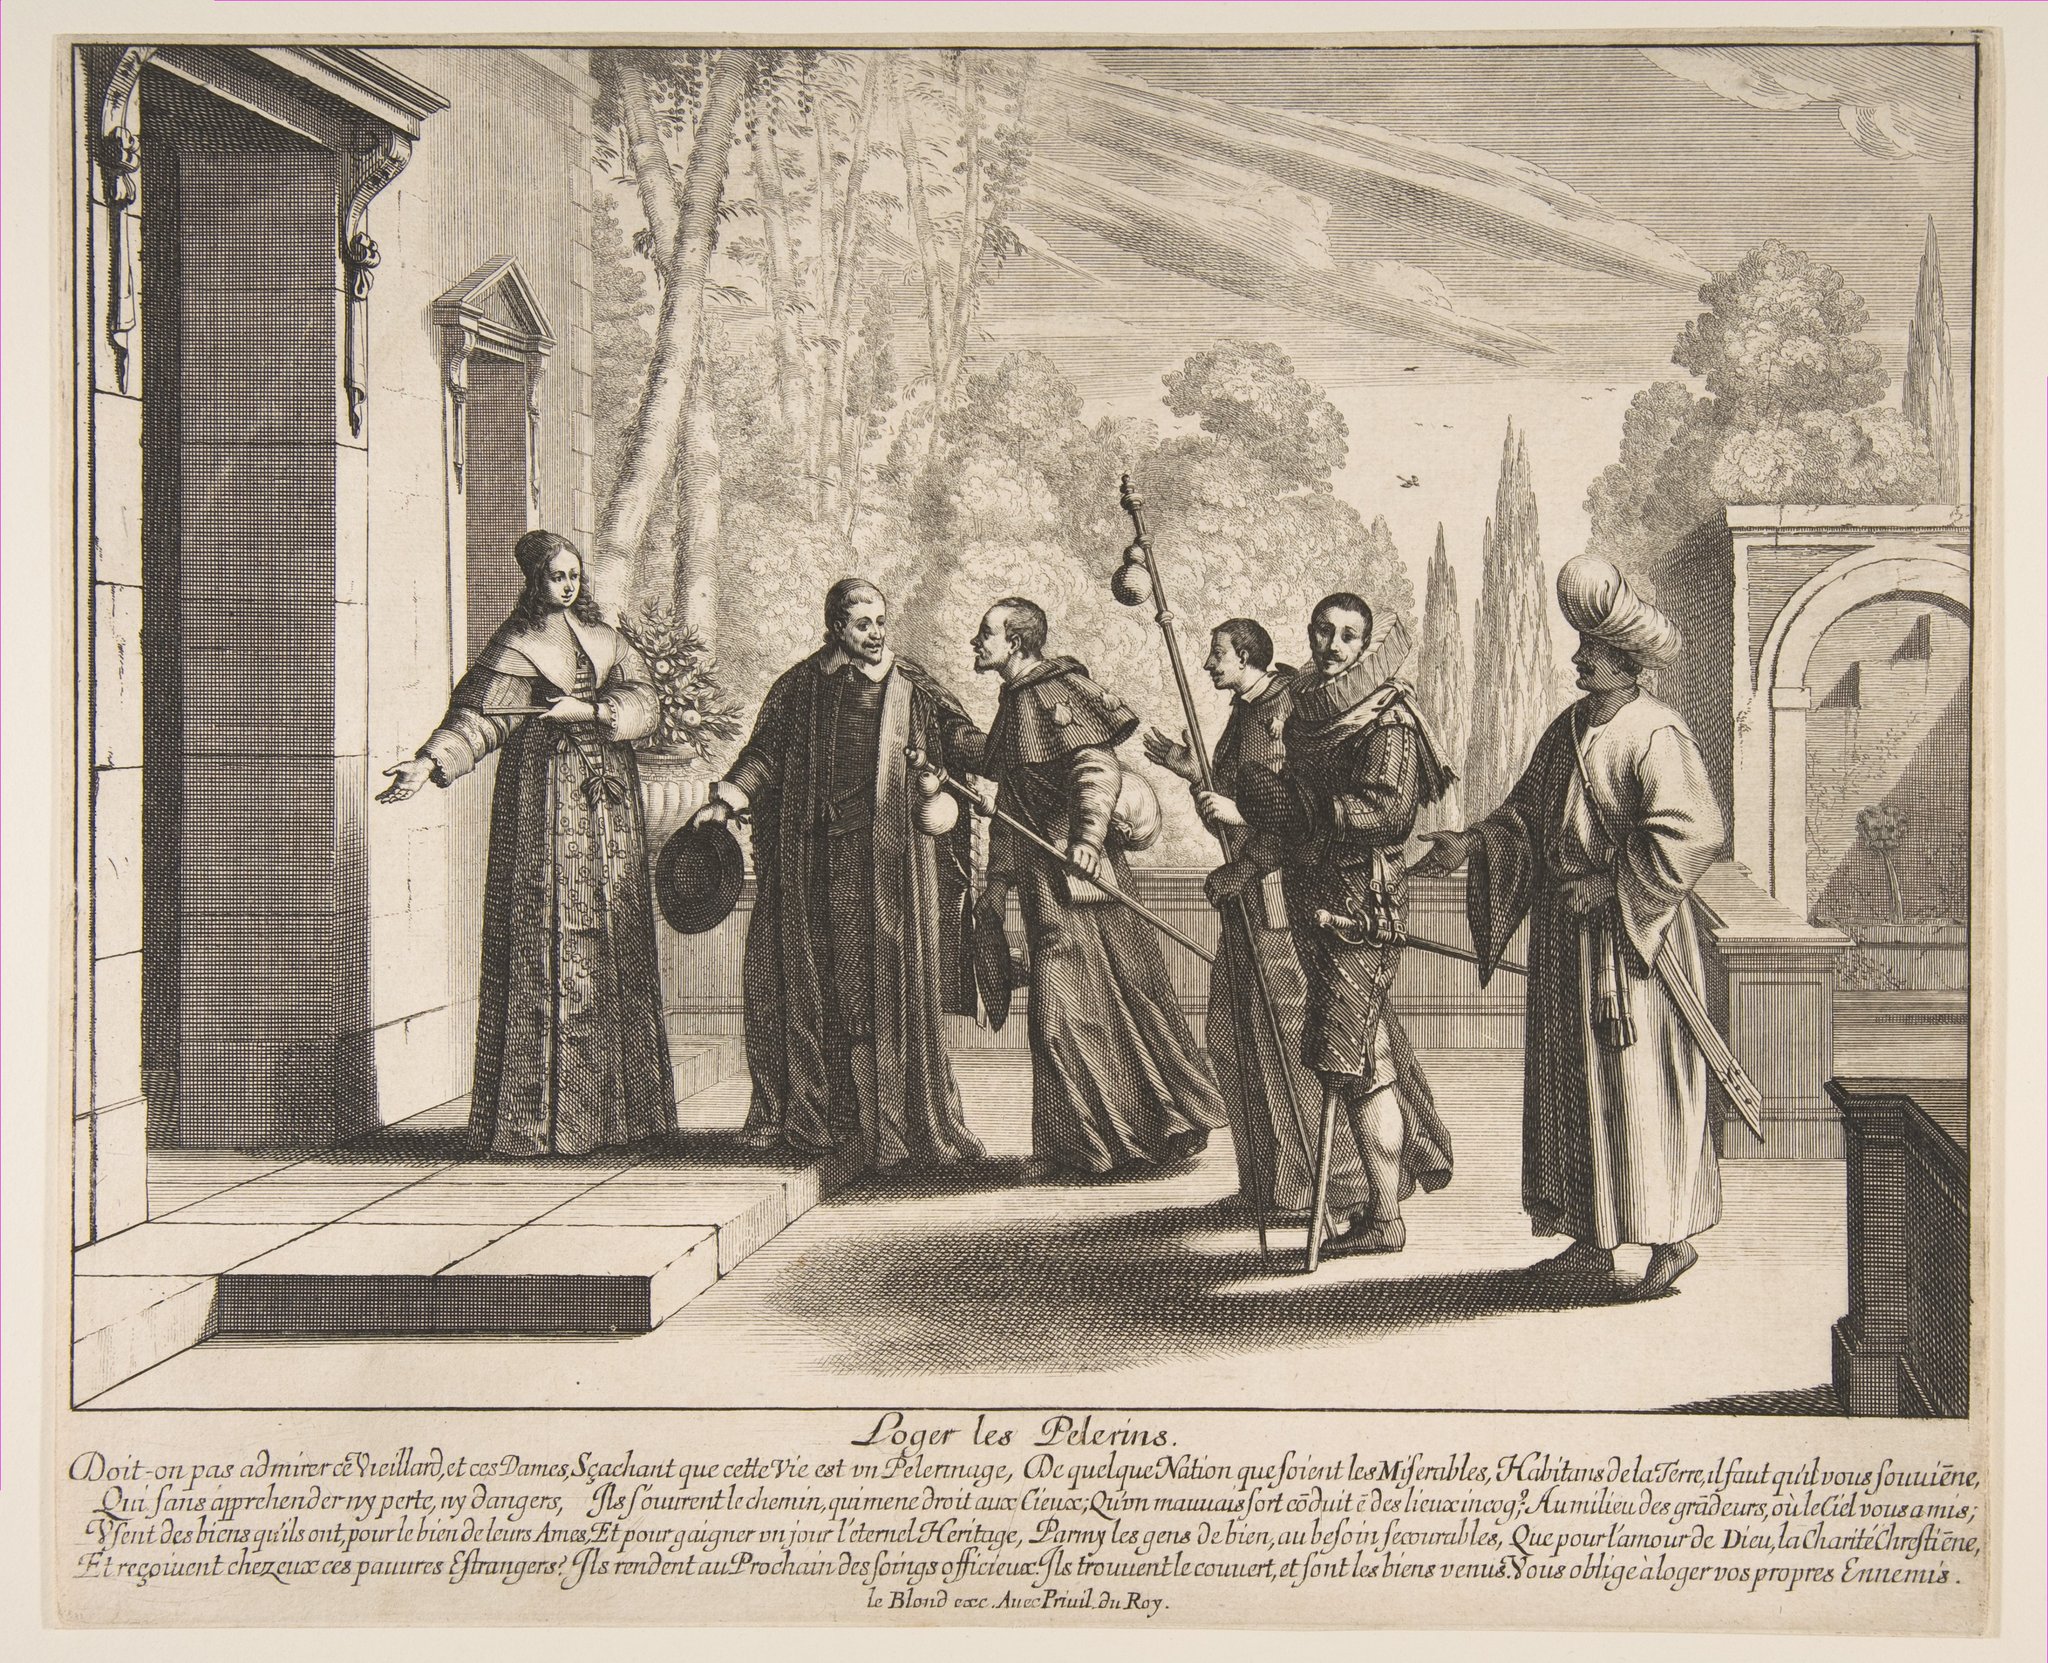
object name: print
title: Lodge the Pilgrims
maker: abraham bosse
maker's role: artist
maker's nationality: french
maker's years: 1602-1676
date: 1635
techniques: engraving, etching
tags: men,women